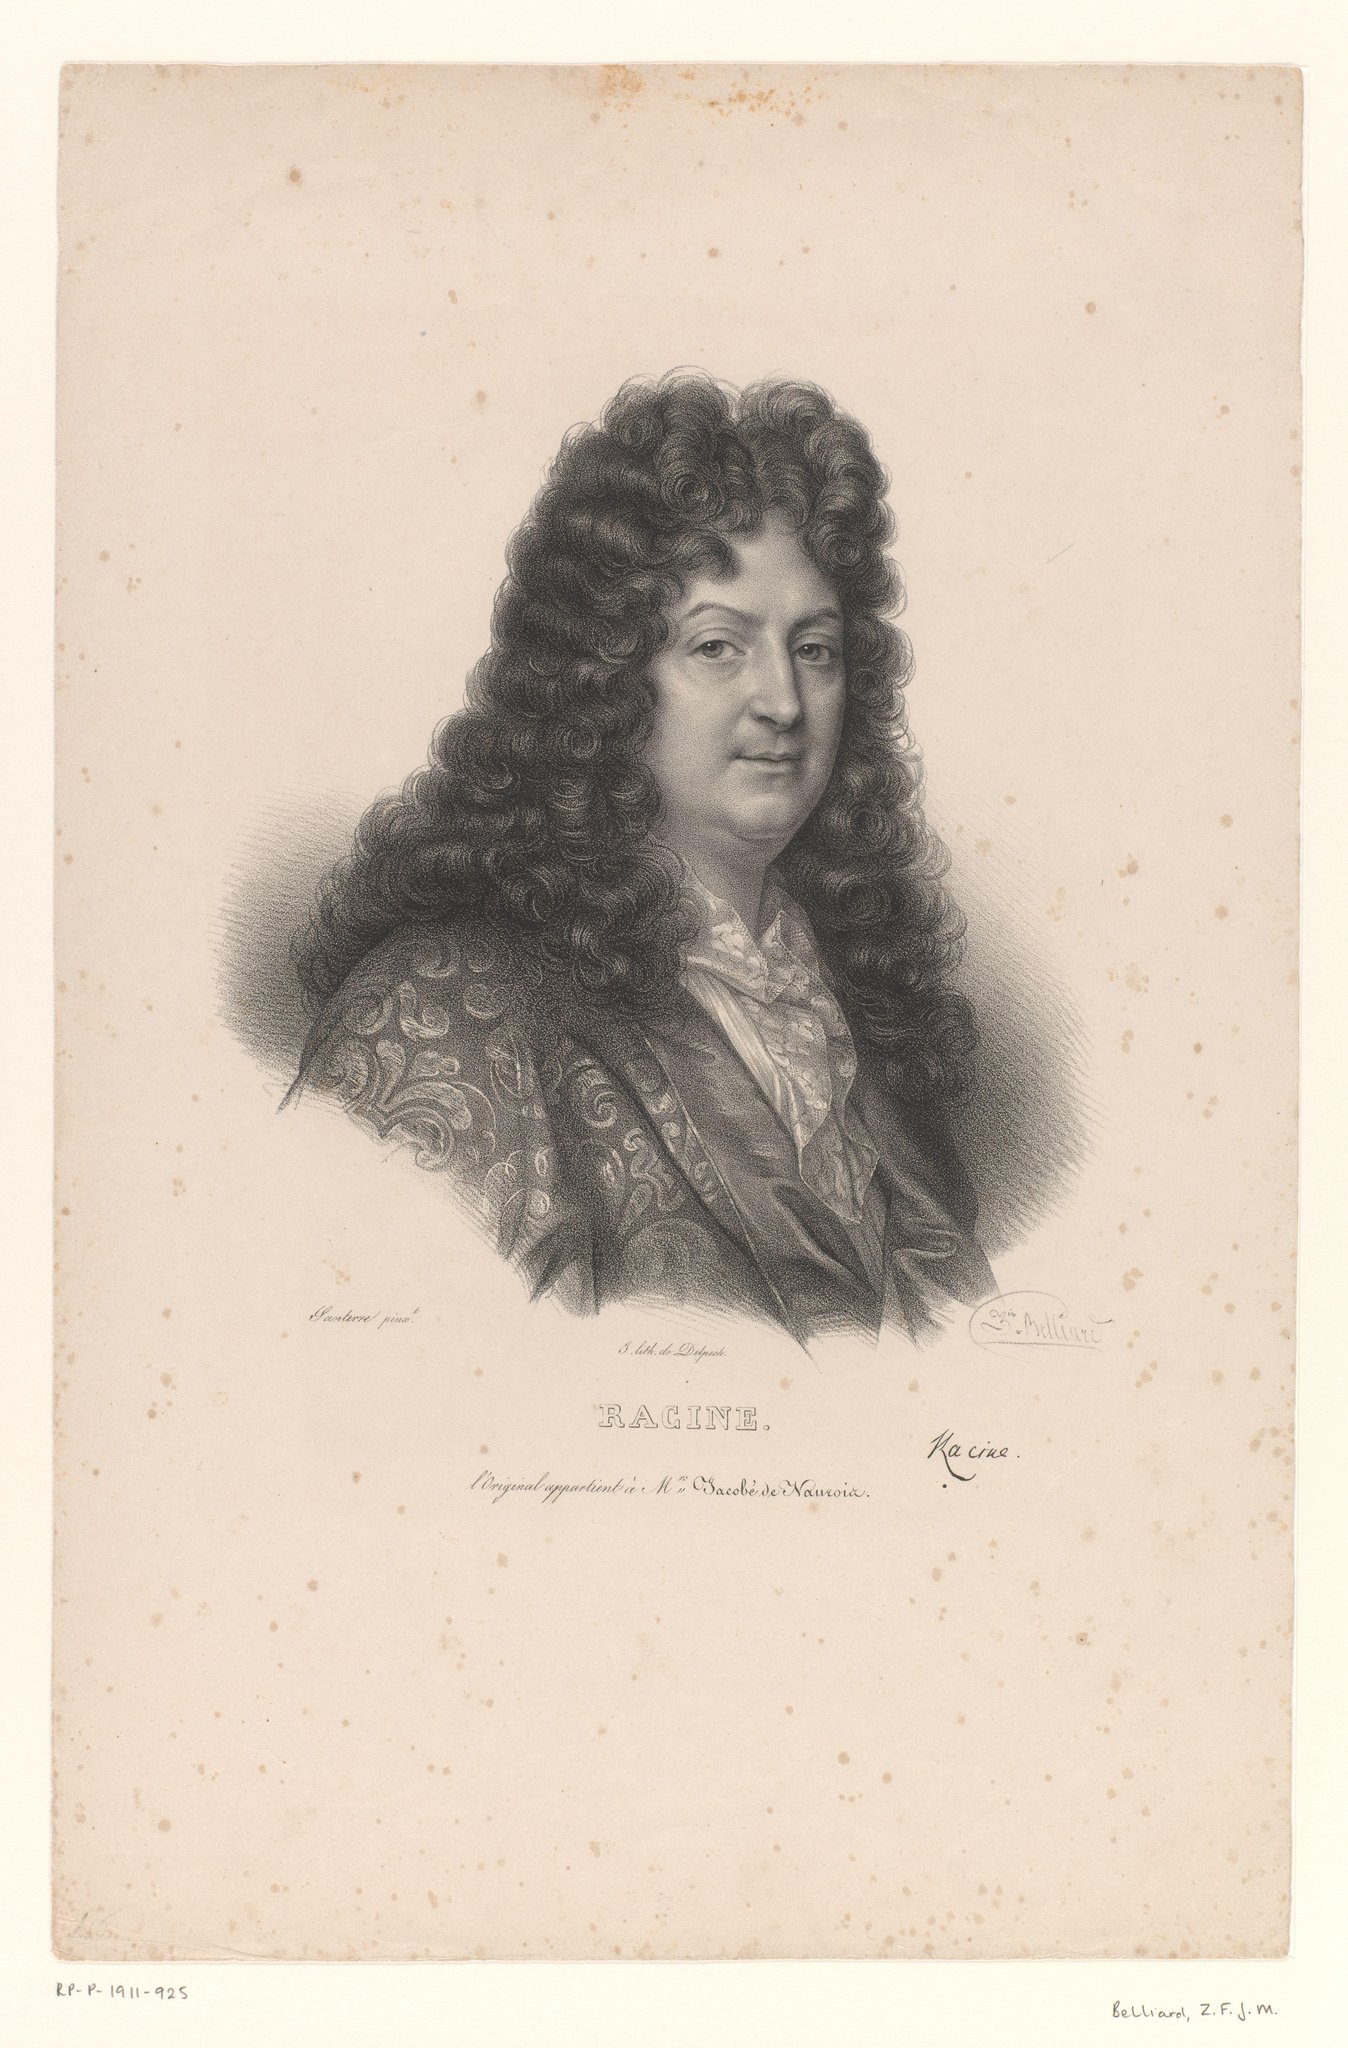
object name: book illustration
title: Tweehonderd portretten tussen de regeringsperioden van Karel VII en Lodewijk XVI van Frankrijk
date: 1829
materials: paper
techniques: lithograph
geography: paris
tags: france, jean racine, historical persons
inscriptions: collector's mark: Lugt 2228a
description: Prent gepubliceerd in: Iconographie française, ou Choix de deux cents portraits d'hommes et de femmes depuis le règne de Charles VII jusqu'à la fin de celui de Louis XVI, publié par Madame Delpech, Parijs 1840.